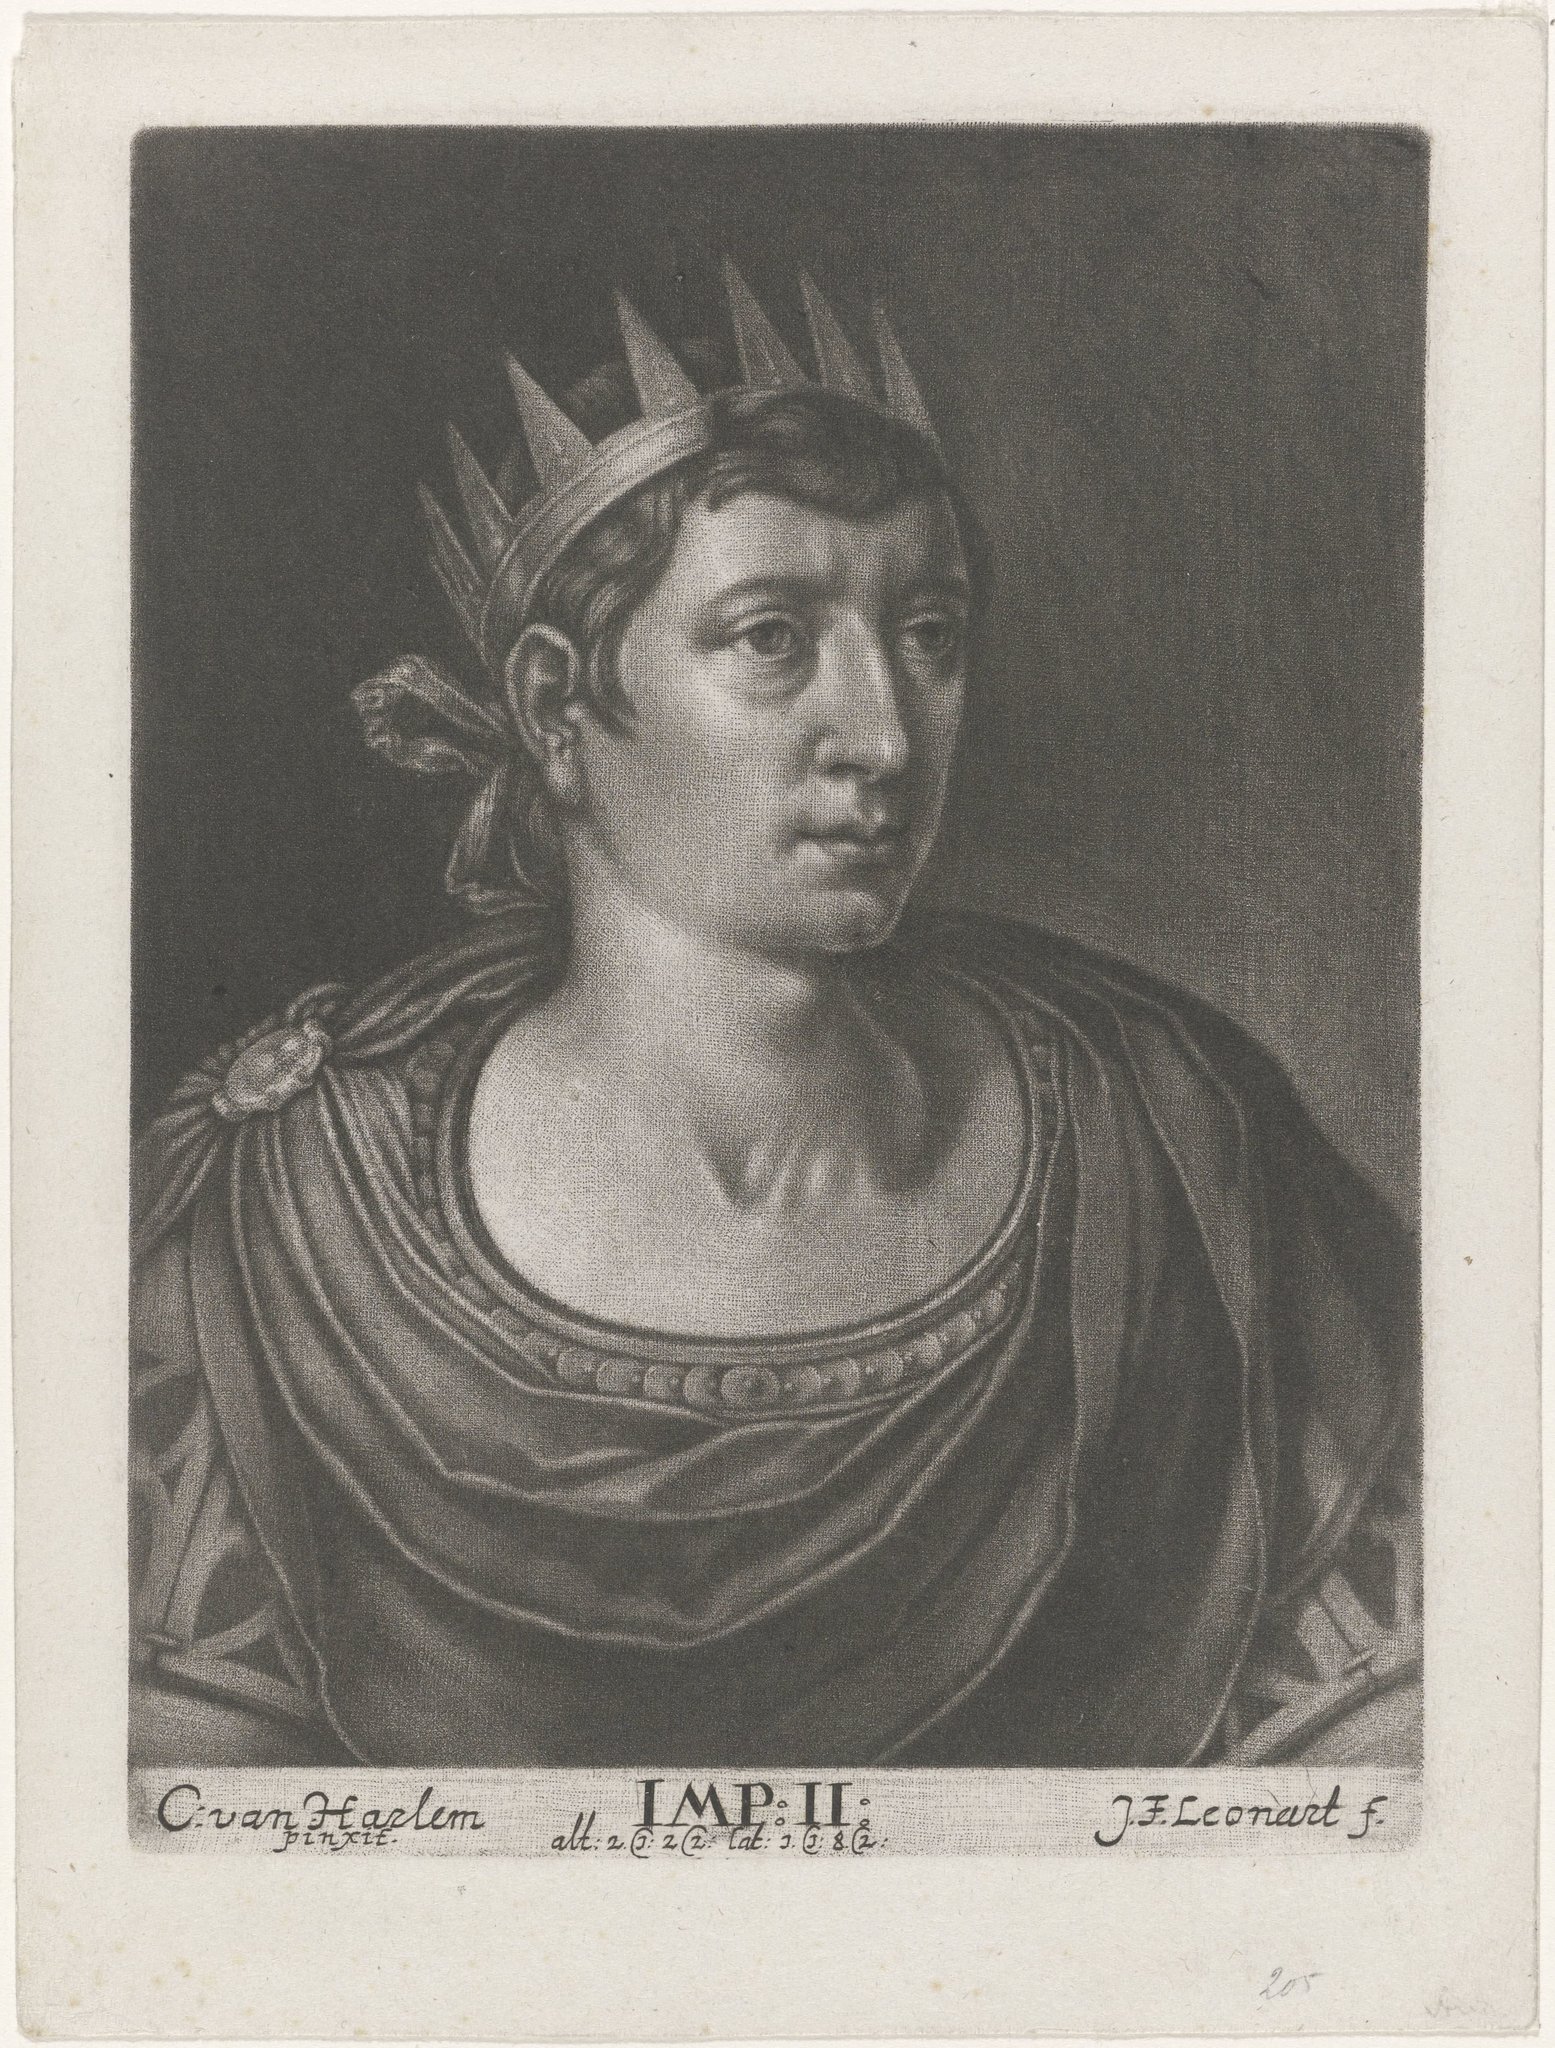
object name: print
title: Romeinse keizers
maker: johann friedrich leonard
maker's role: print maker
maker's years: 1633-1680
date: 1643-1680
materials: paper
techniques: engraving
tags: crown (symbol of sovereignty)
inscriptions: collector's mark: Lugt 2166